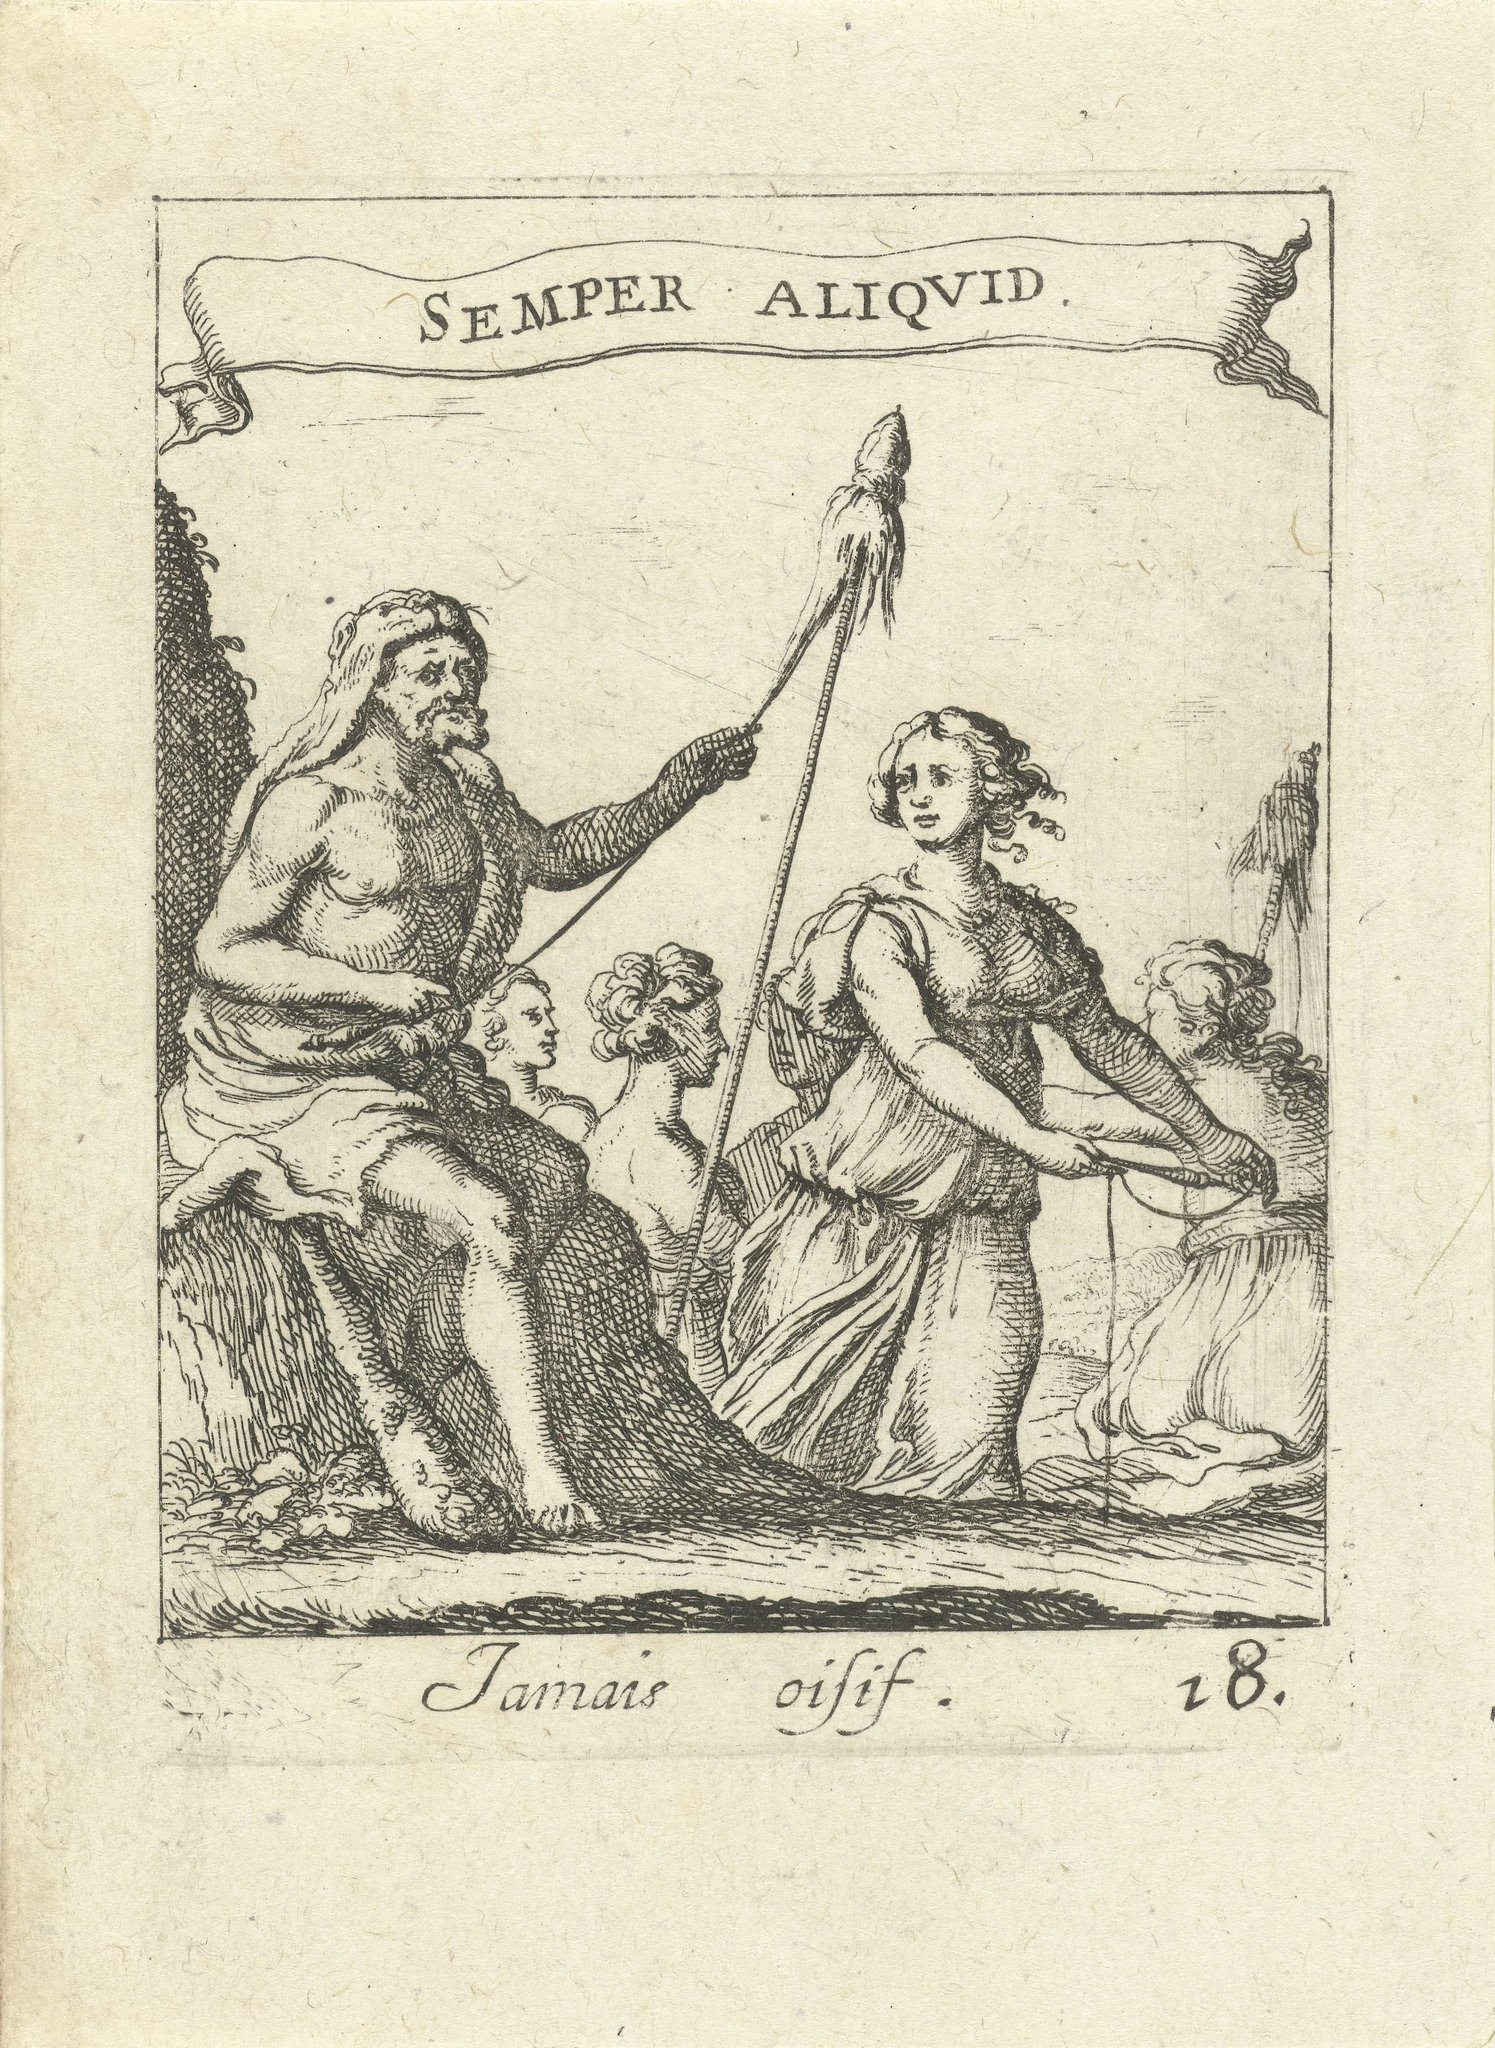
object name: print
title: Devises et emblesmes d'amovr moralisez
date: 1672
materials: paper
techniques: etching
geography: paris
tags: qualities of love: first series (+ emblematical representation of concept)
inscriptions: collector's mark: Lugt 2166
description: Hercules, met leeuwenvel en knots, spint een draad. Op de achtergrond spinnende vrouwen. Op een banderol een devies in Latijn en een onderschrift in Frans, beide over de liefde.